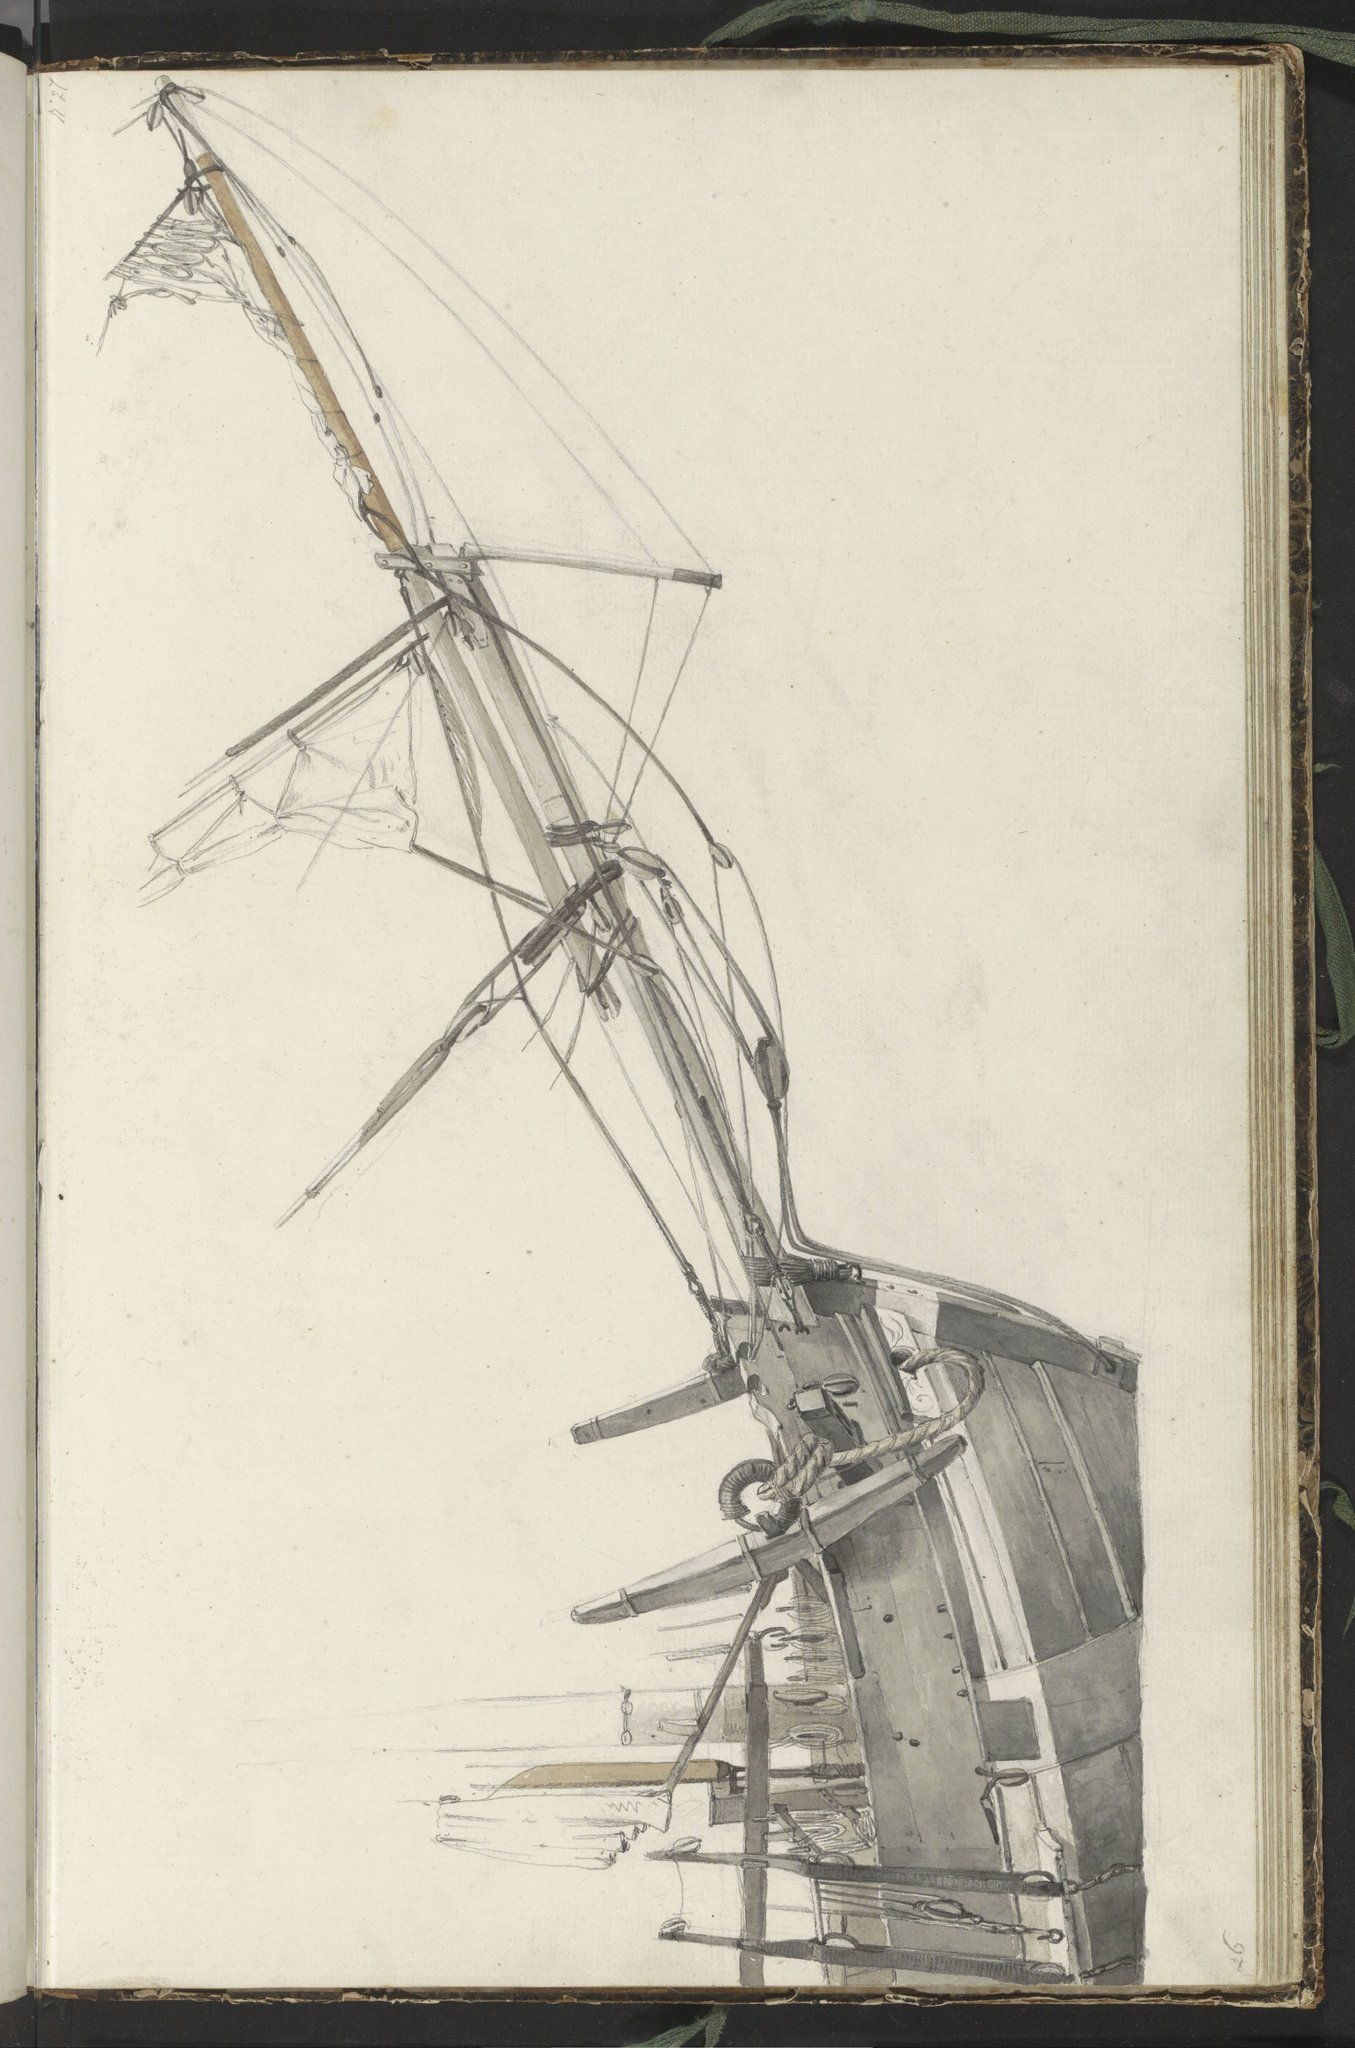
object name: sketchbook leaf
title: Voorsteven van een zeilschip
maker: johannes christiaan schotel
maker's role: draughtsman, painter, print maker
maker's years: 1787-1838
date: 1797-1838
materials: paper, pencil, watercolor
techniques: brush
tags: sailing-ship, sailing-boat, parts of ship's exterior: bow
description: Blad 26 recto uit een schetsboek met 44 bladen.